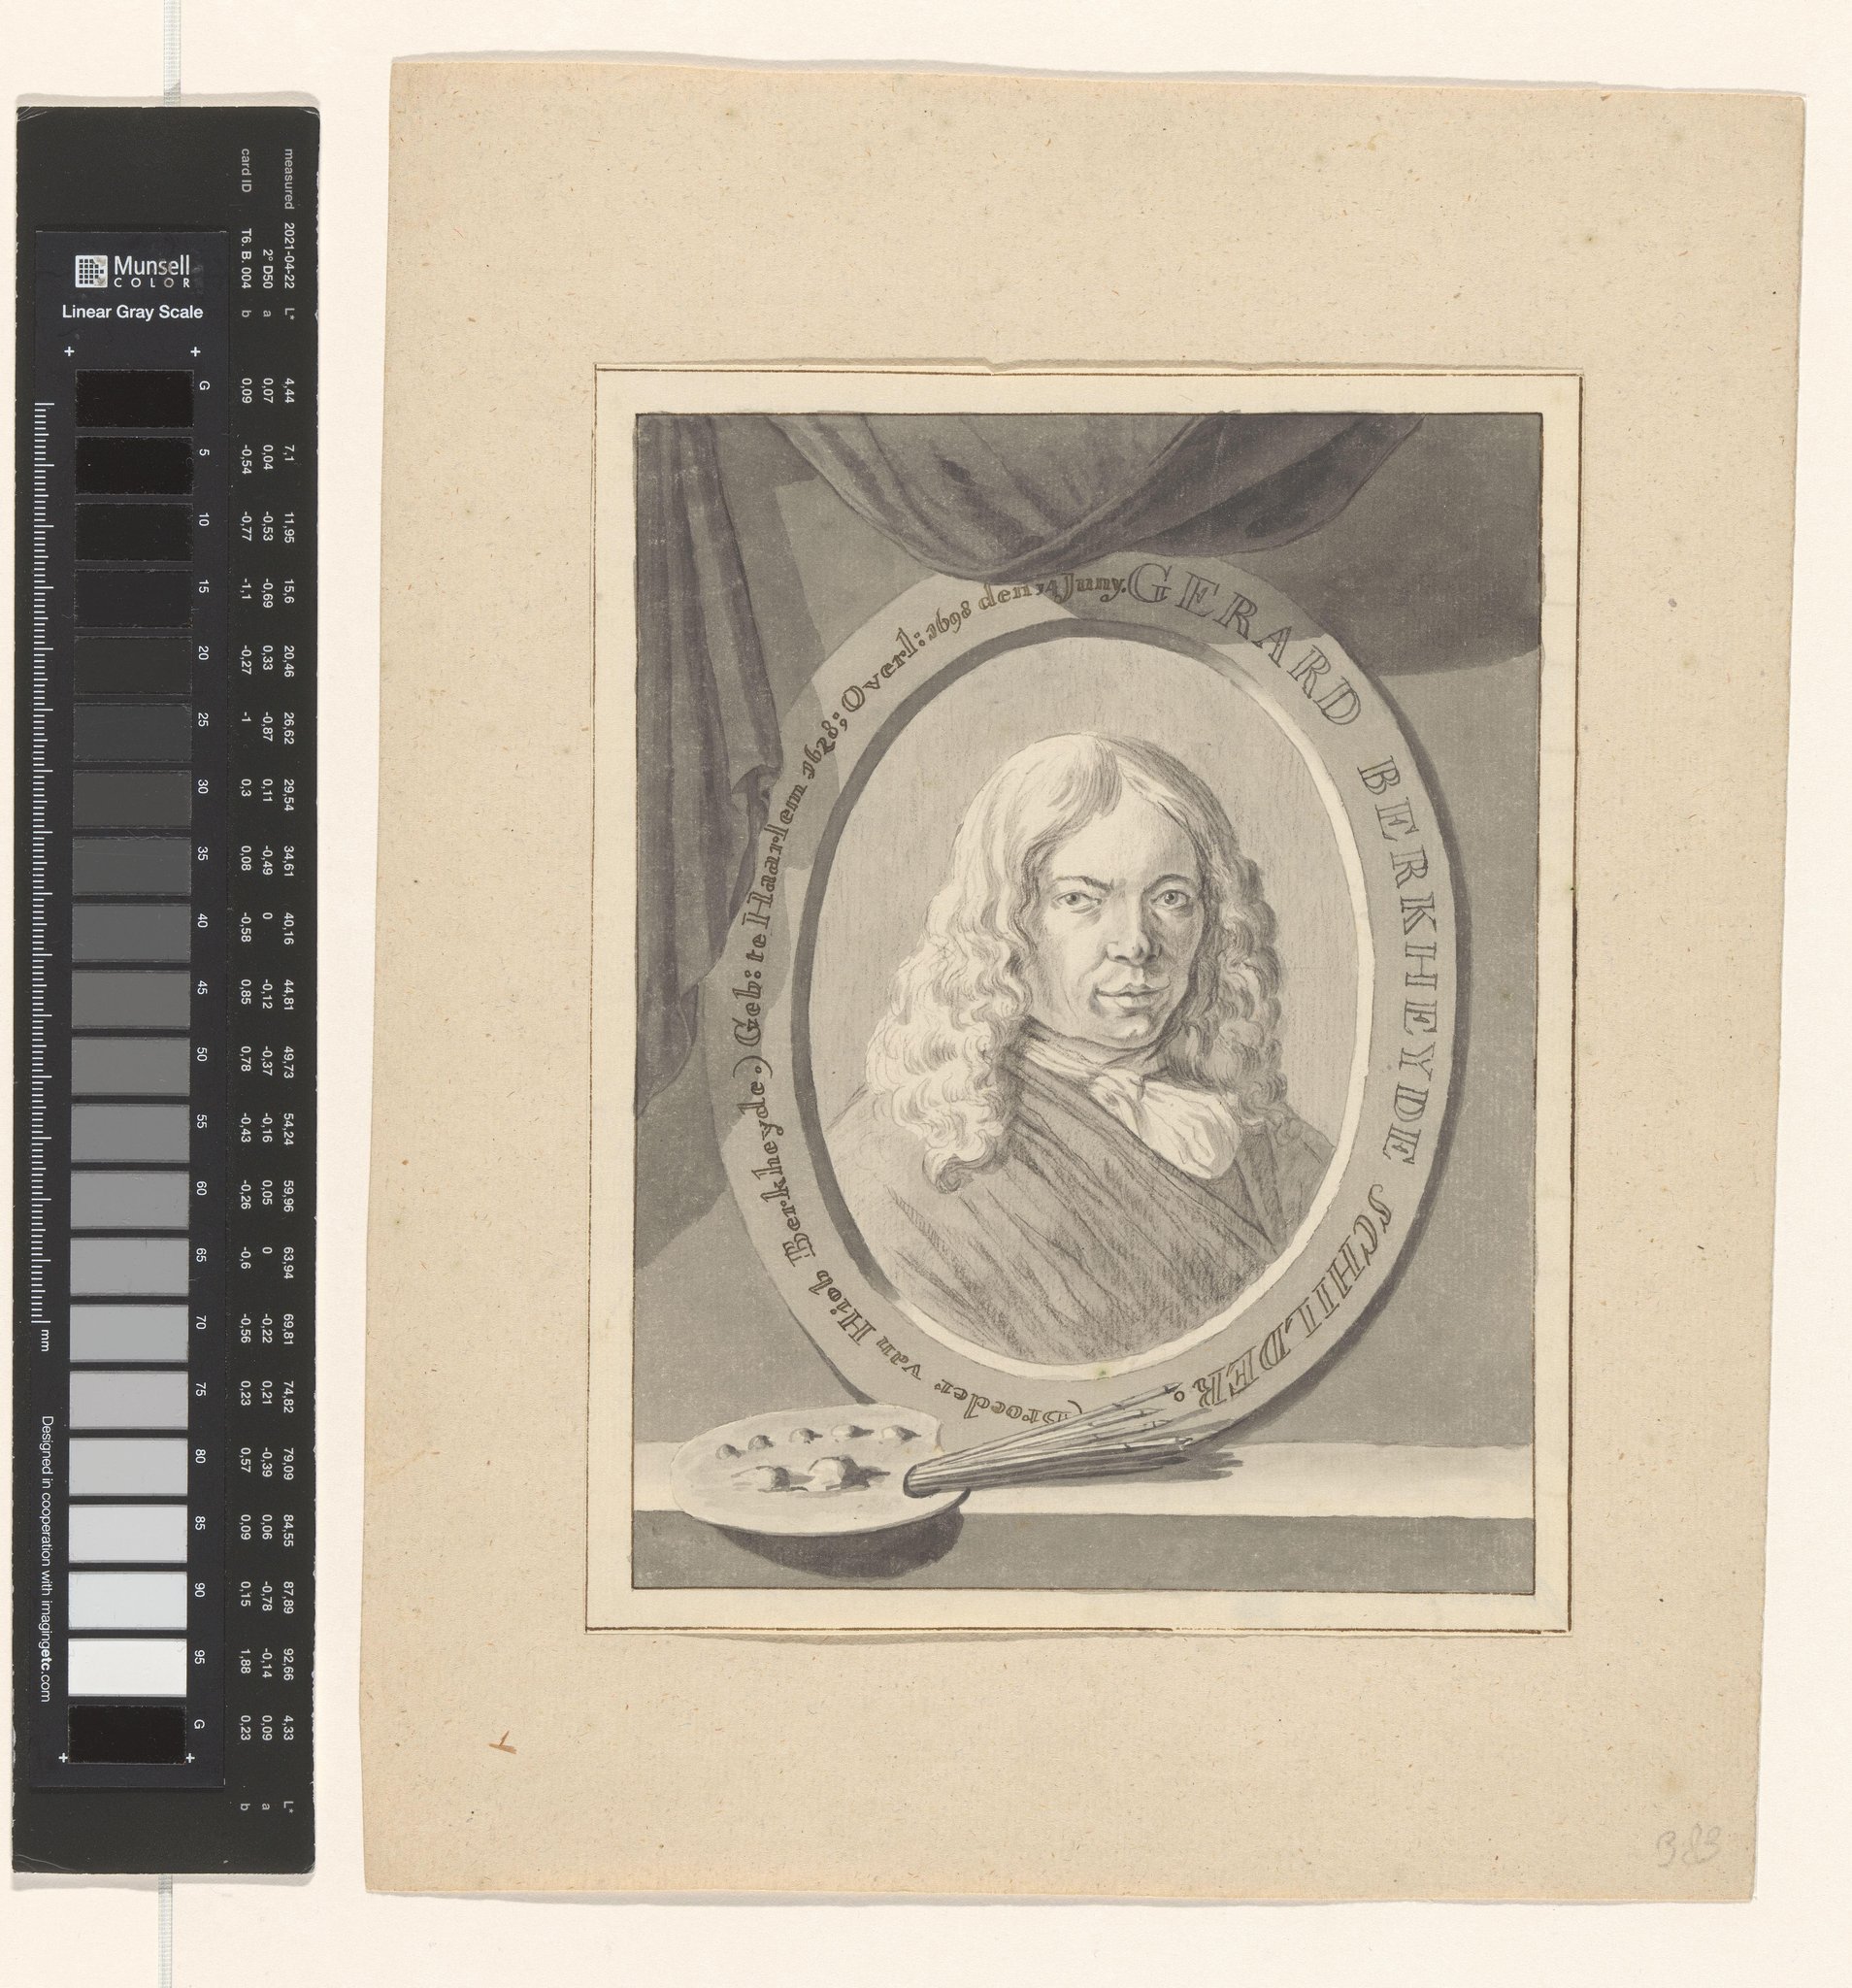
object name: drawing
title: Portret van de kunstschilder Gerrit Berckheyde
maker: Anonymous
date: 1725-1775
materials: chalk, pencil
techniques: brush, pen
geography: netherlands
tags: haarlem, painter, draughtsman, gerrit berckheyde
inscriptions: inscription: ‘Geraerd Berkheyde Pictor Haerlemensis 1690.’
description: Betiteld op het ovaal rond het portret en op de achterzijde, beide in contemporain handschrift.